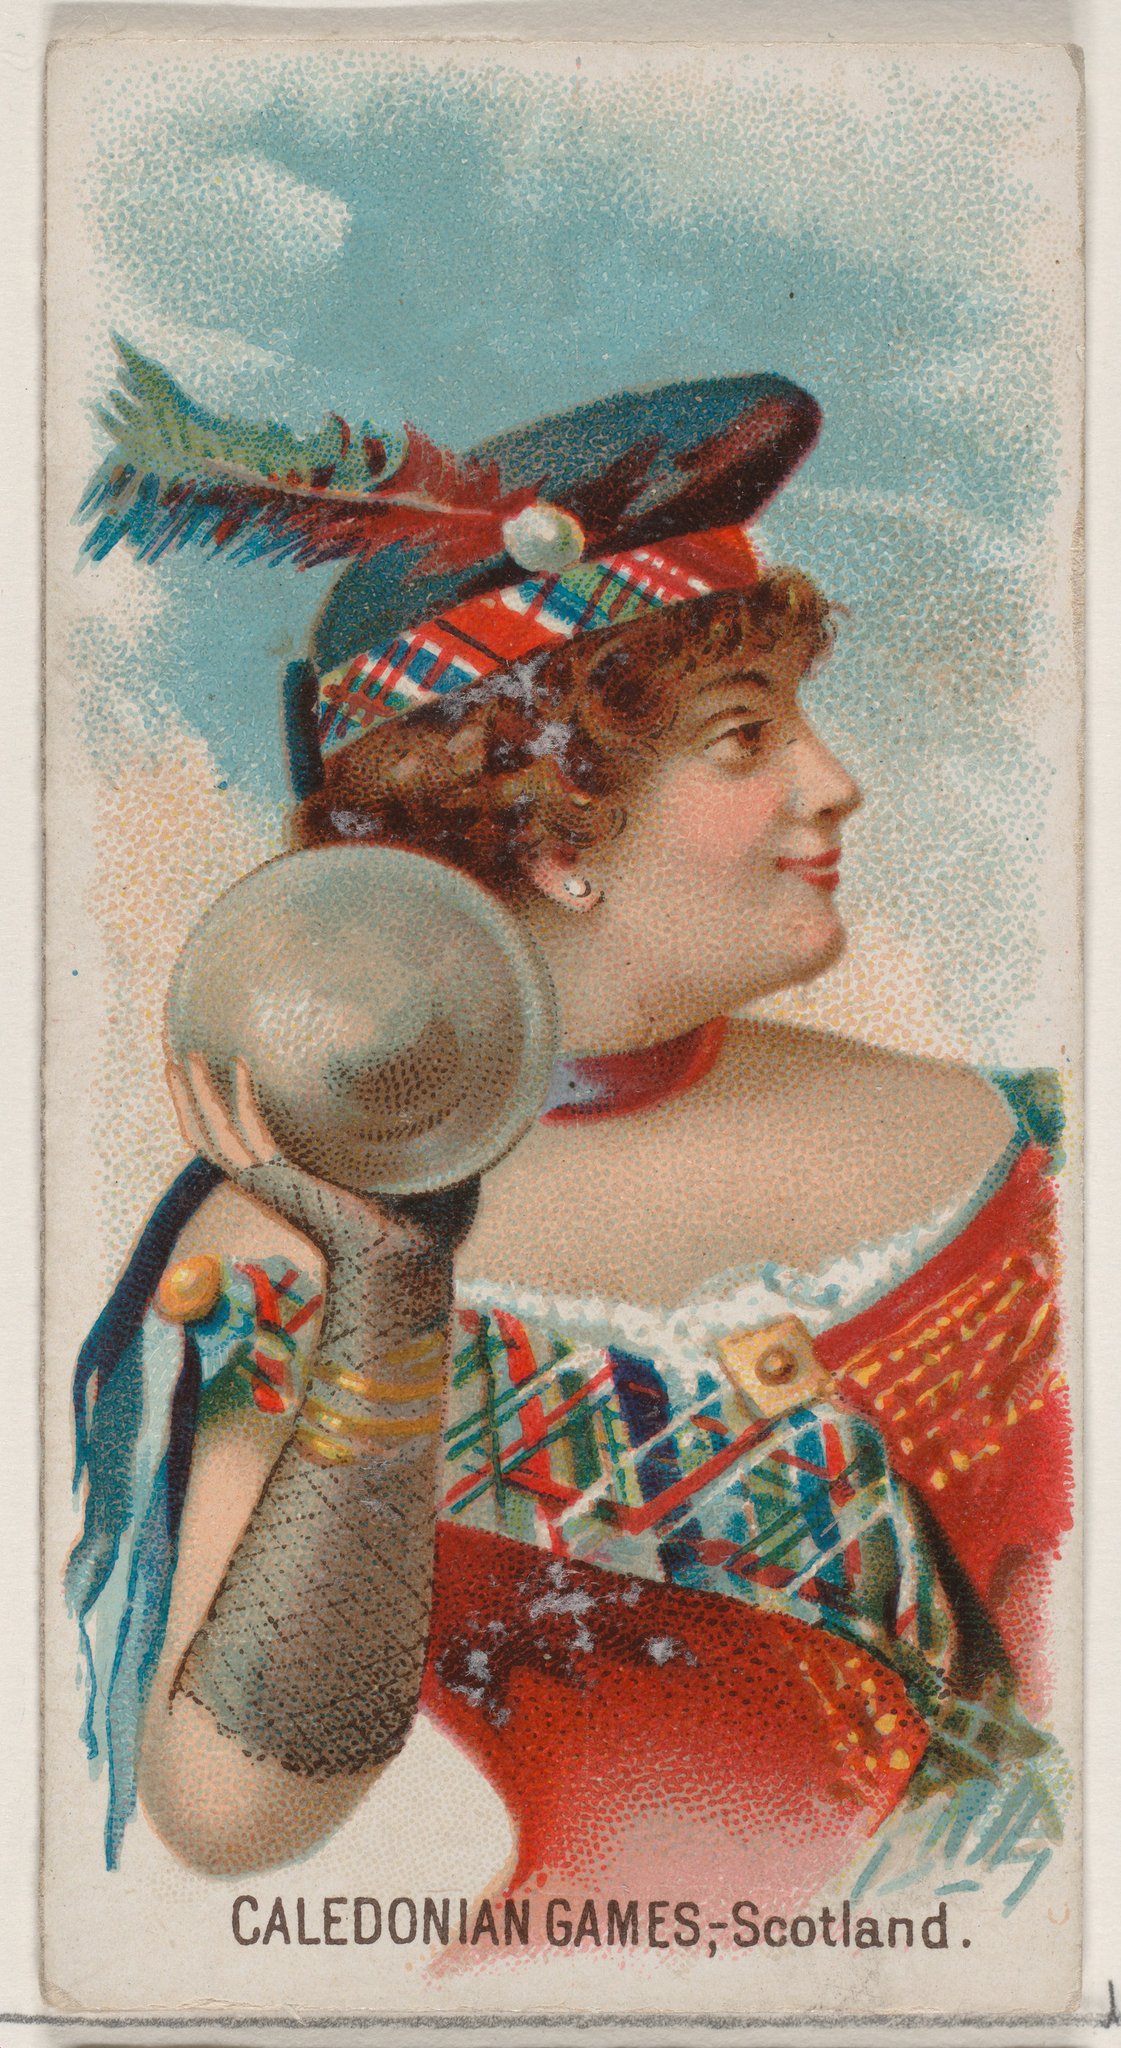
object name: print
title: Caledonian Games, Scotland, from the Holidays series (N80) for Duke brand cigarettes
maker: w. duke, sons & co.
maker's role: publisher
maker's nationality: american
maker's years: 1870-1920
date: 1890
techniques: color lithograph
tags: women